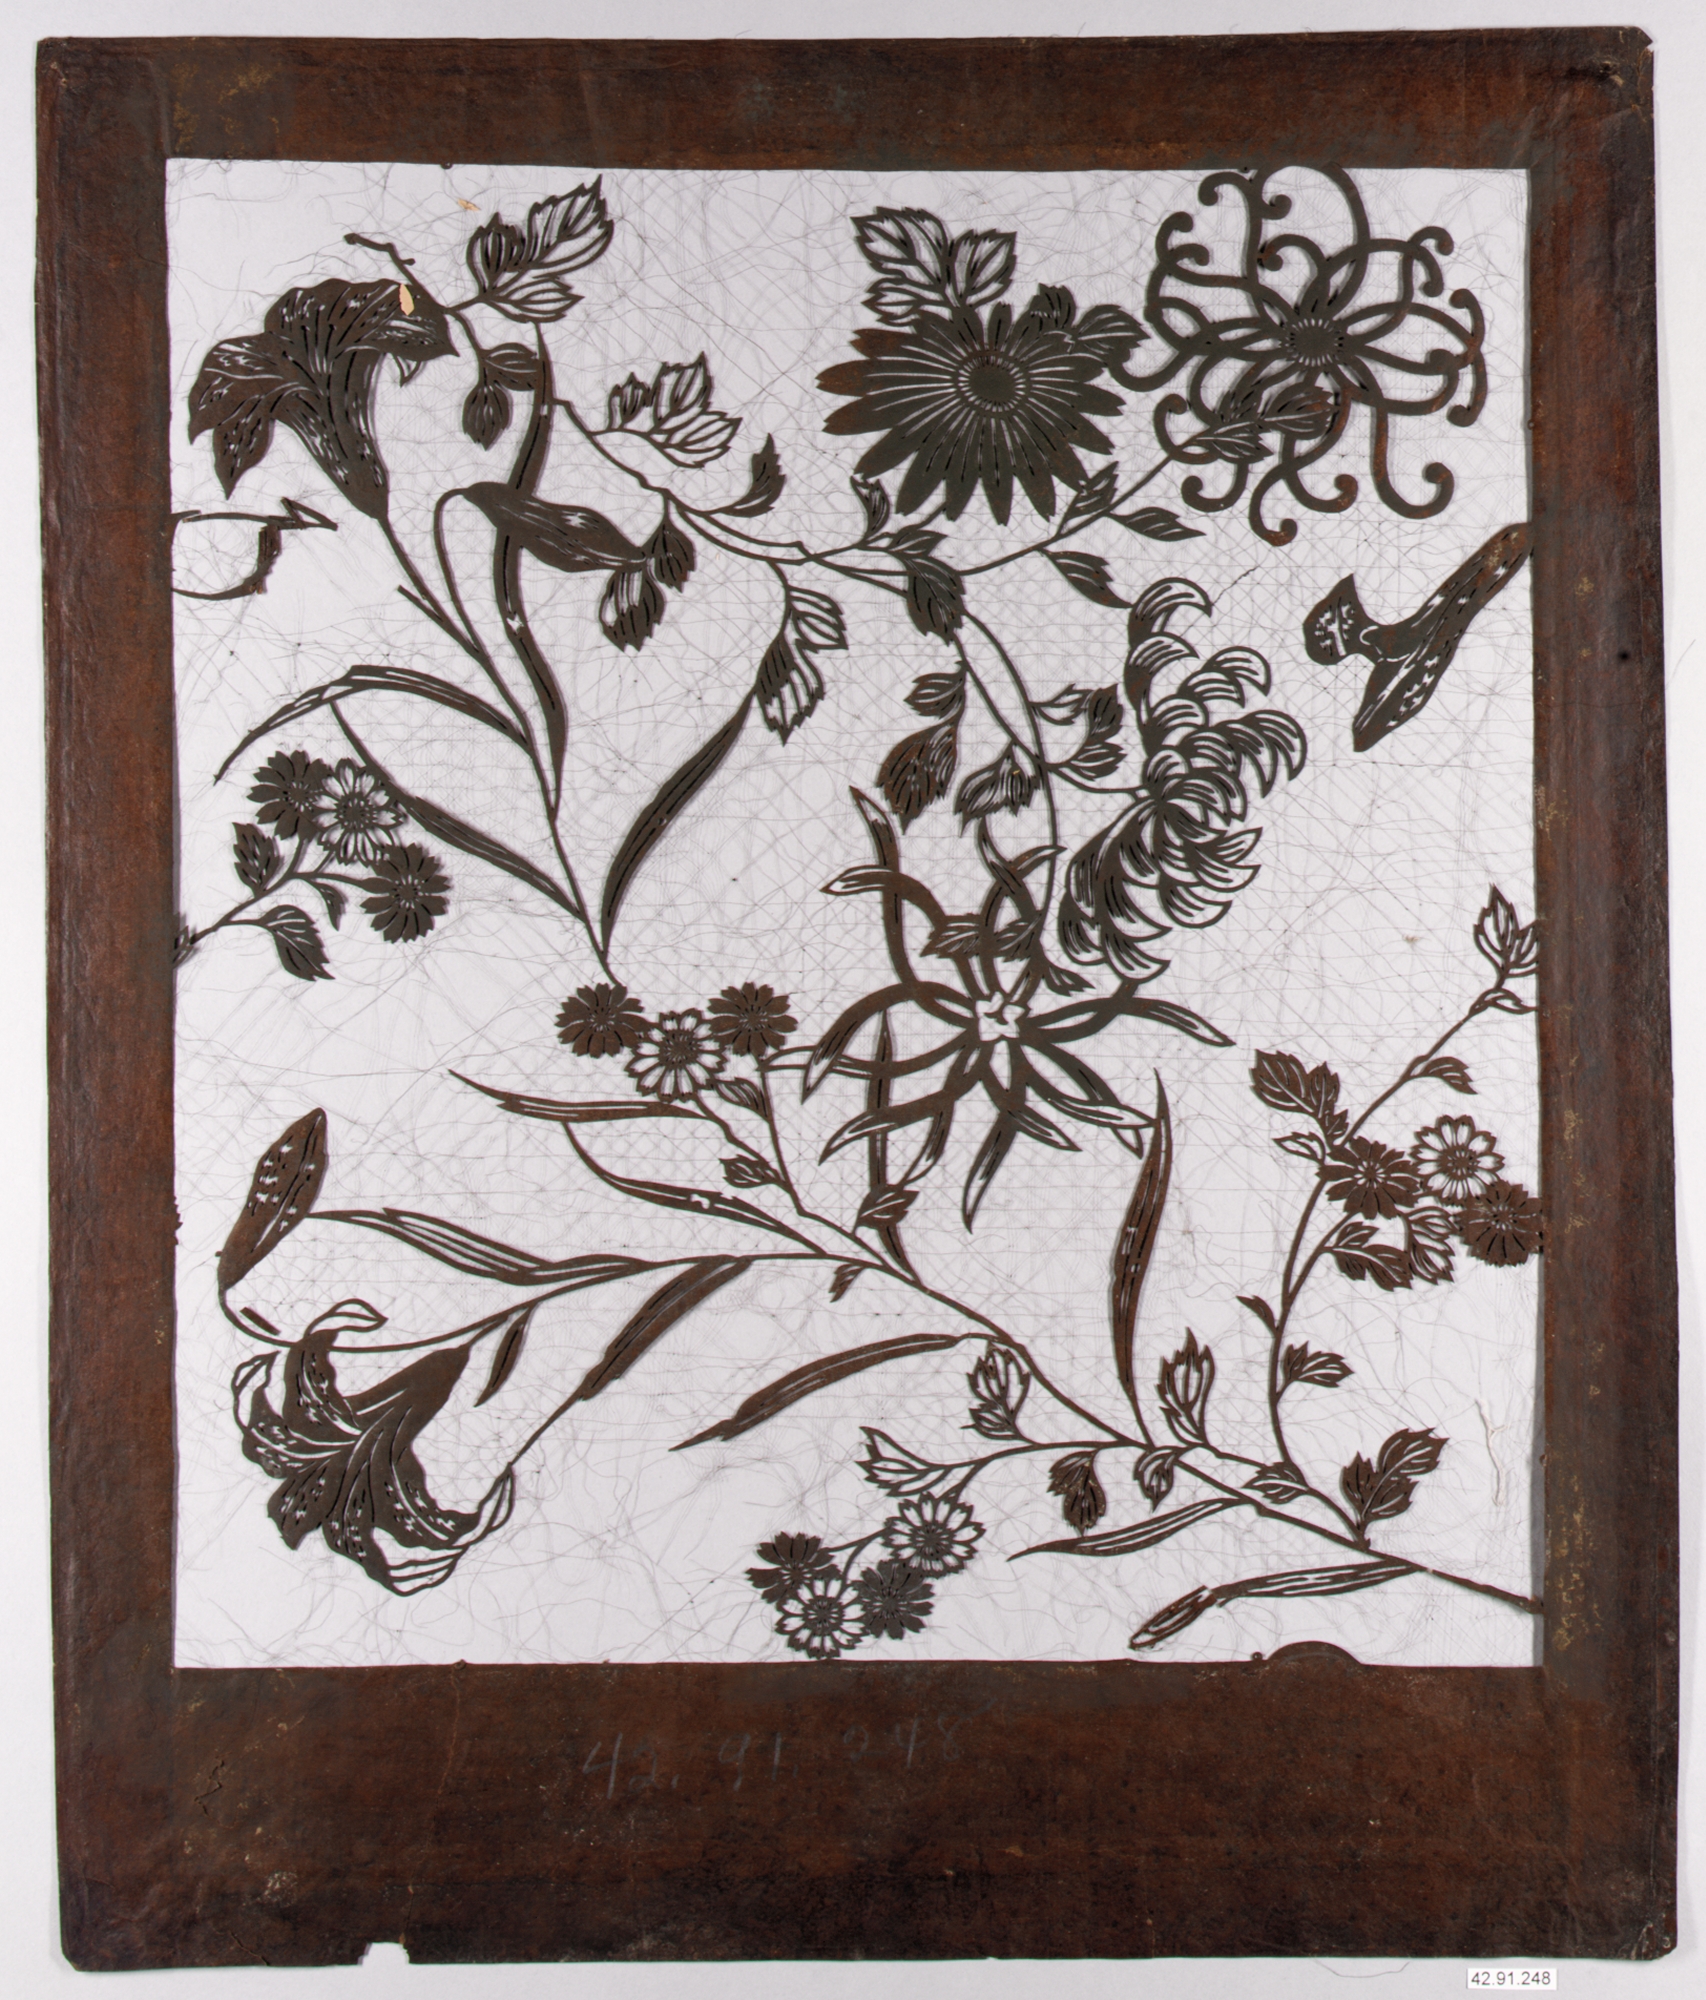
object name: stencil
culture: japanese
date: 1801-1900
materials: paper, silk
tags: flowers,leaves